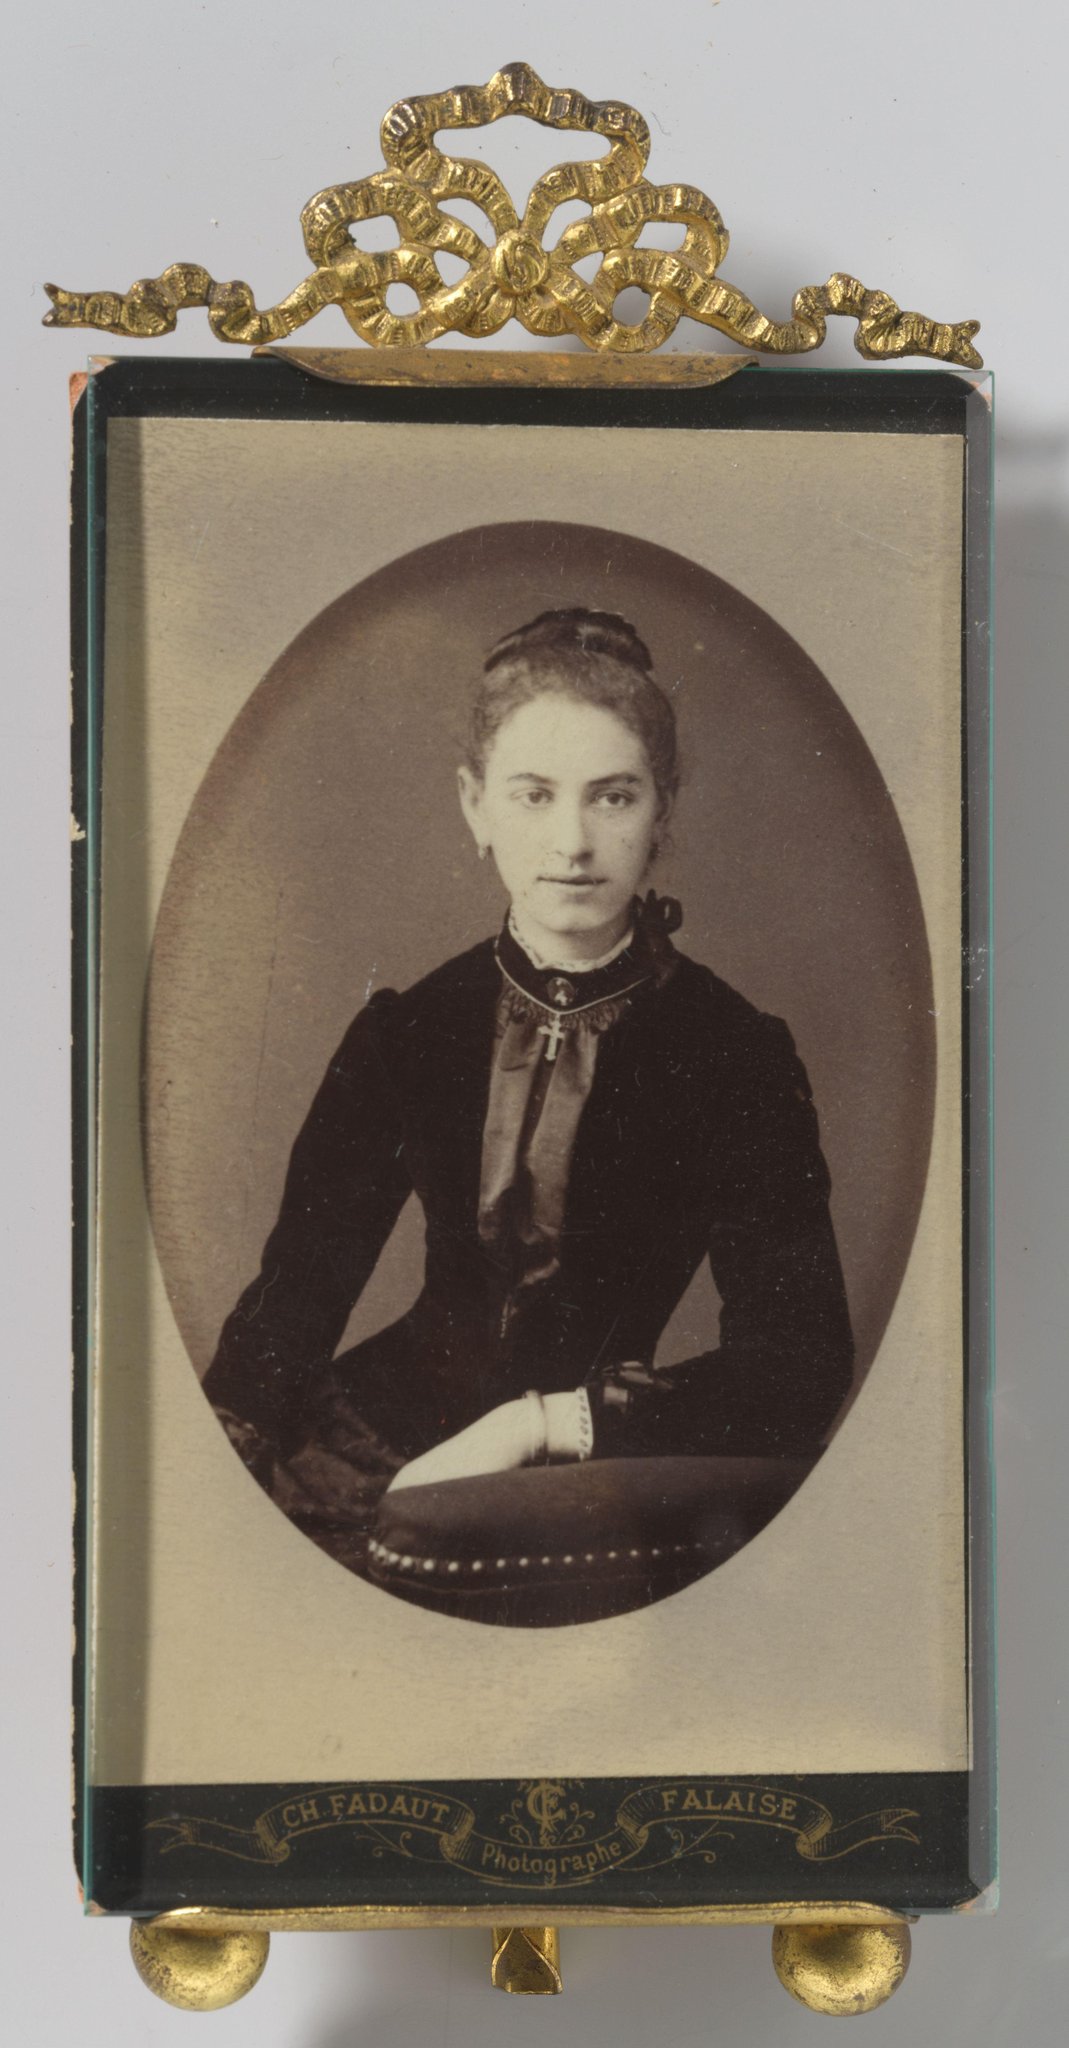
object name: photograph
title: Portret van een onbekende jonge vrouw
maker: charles fadaut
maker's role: fotograaf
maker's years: 1844-1889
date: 1881-1889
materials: cardboard, glass, metal, paper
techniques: albumen print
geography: falaise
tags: adolescent, young woman, maiden, anonymous historical person portrayed